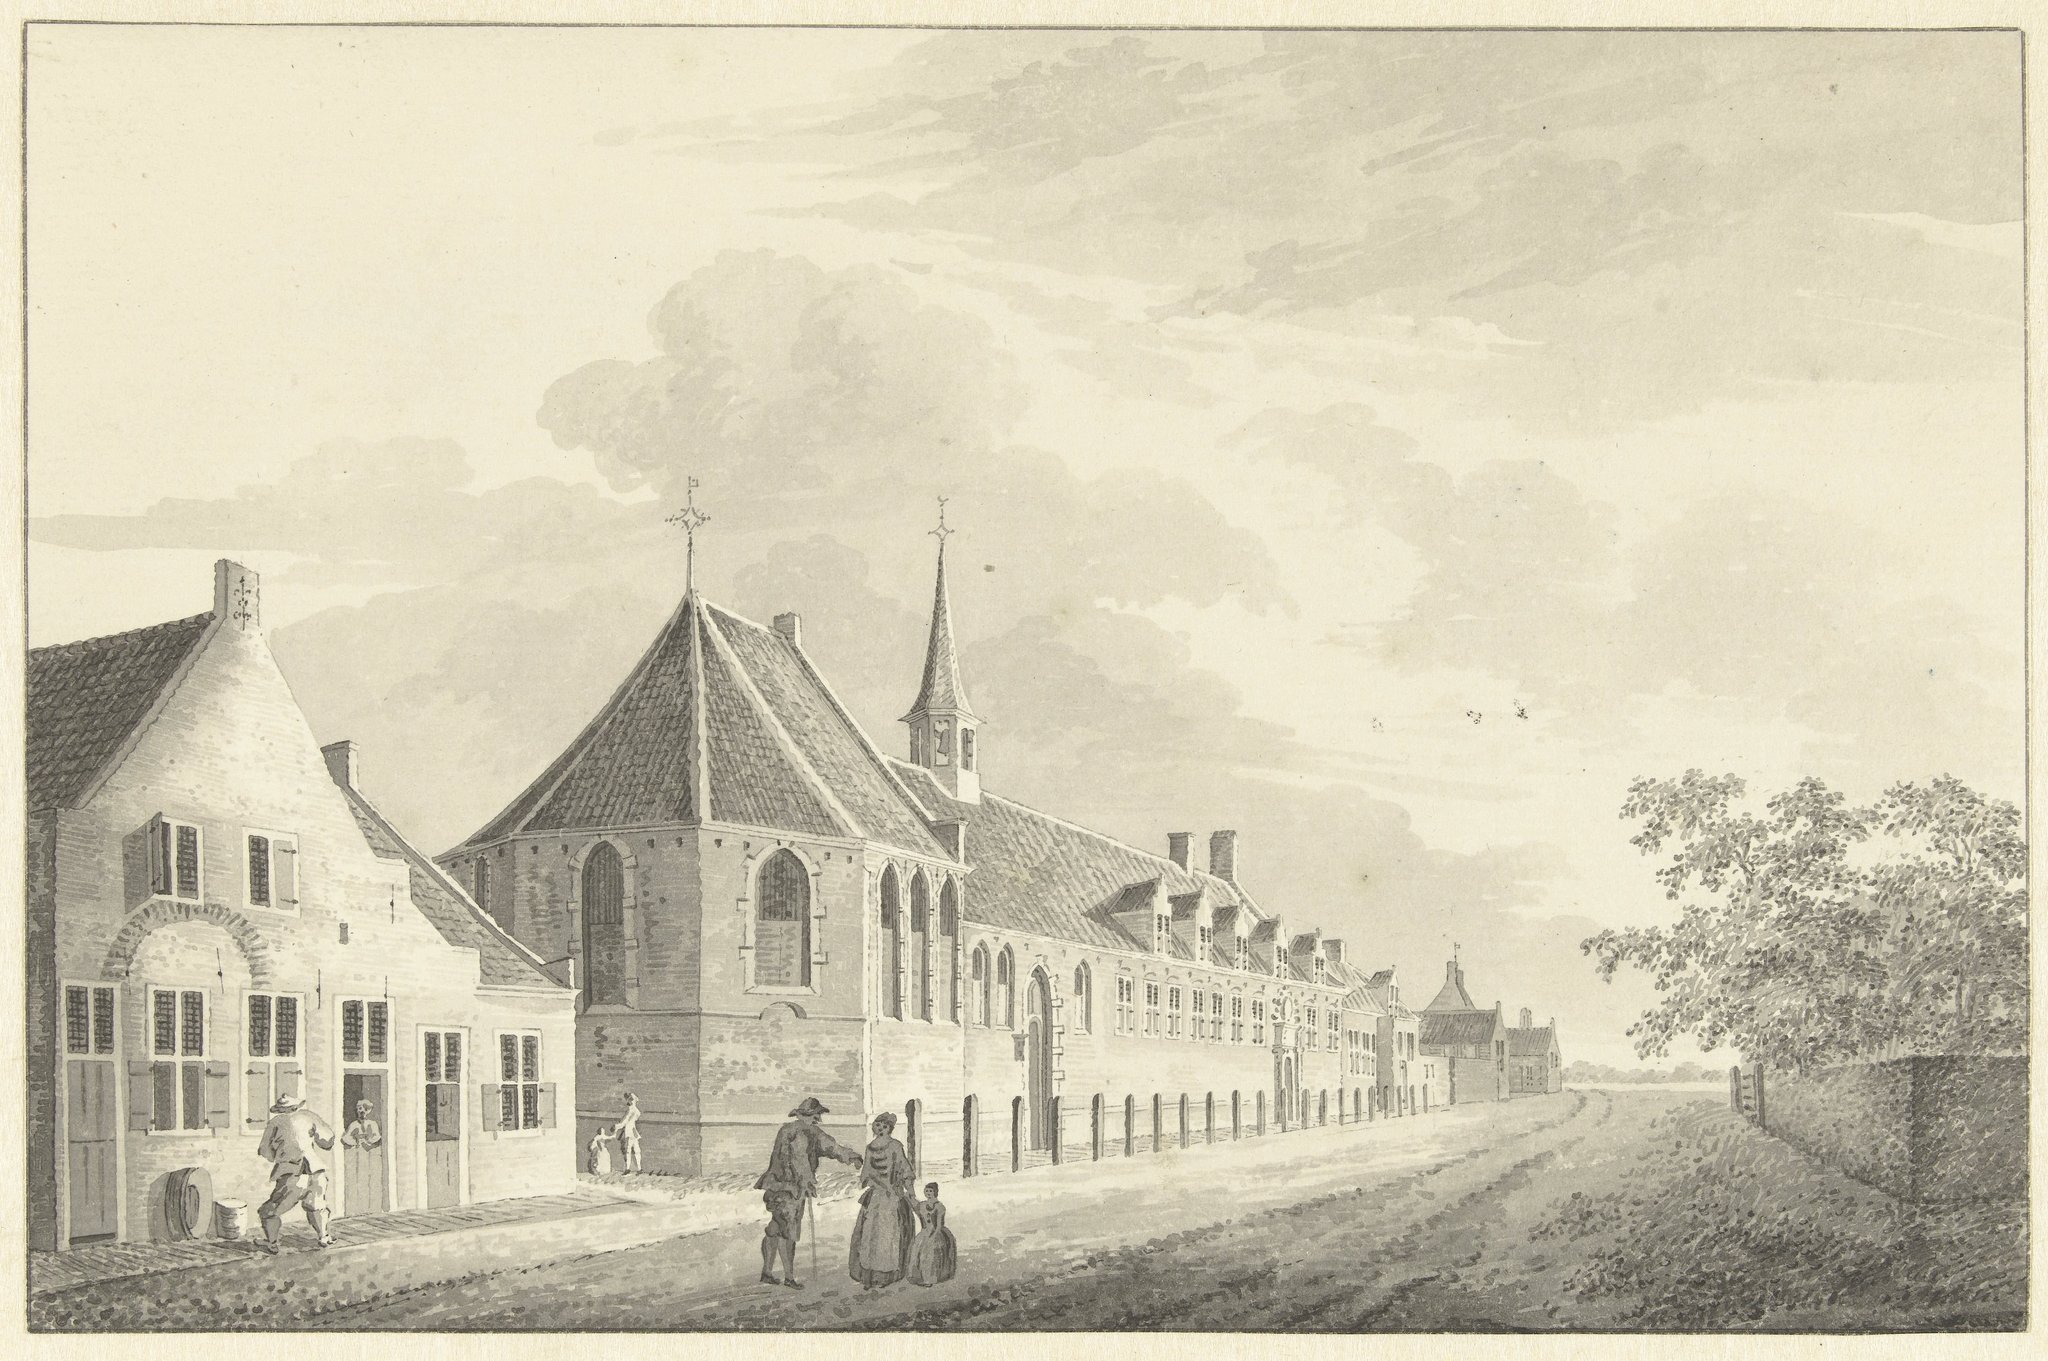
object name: drawing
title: Het St. Jobsgasthuis bij Utrecht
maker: hendrik gerbrand schutter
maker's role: draughtsman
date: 1756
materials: paper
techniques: brush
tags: hospital, church (exterior) - qq - small church, chapel, utrecht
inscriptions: inscription